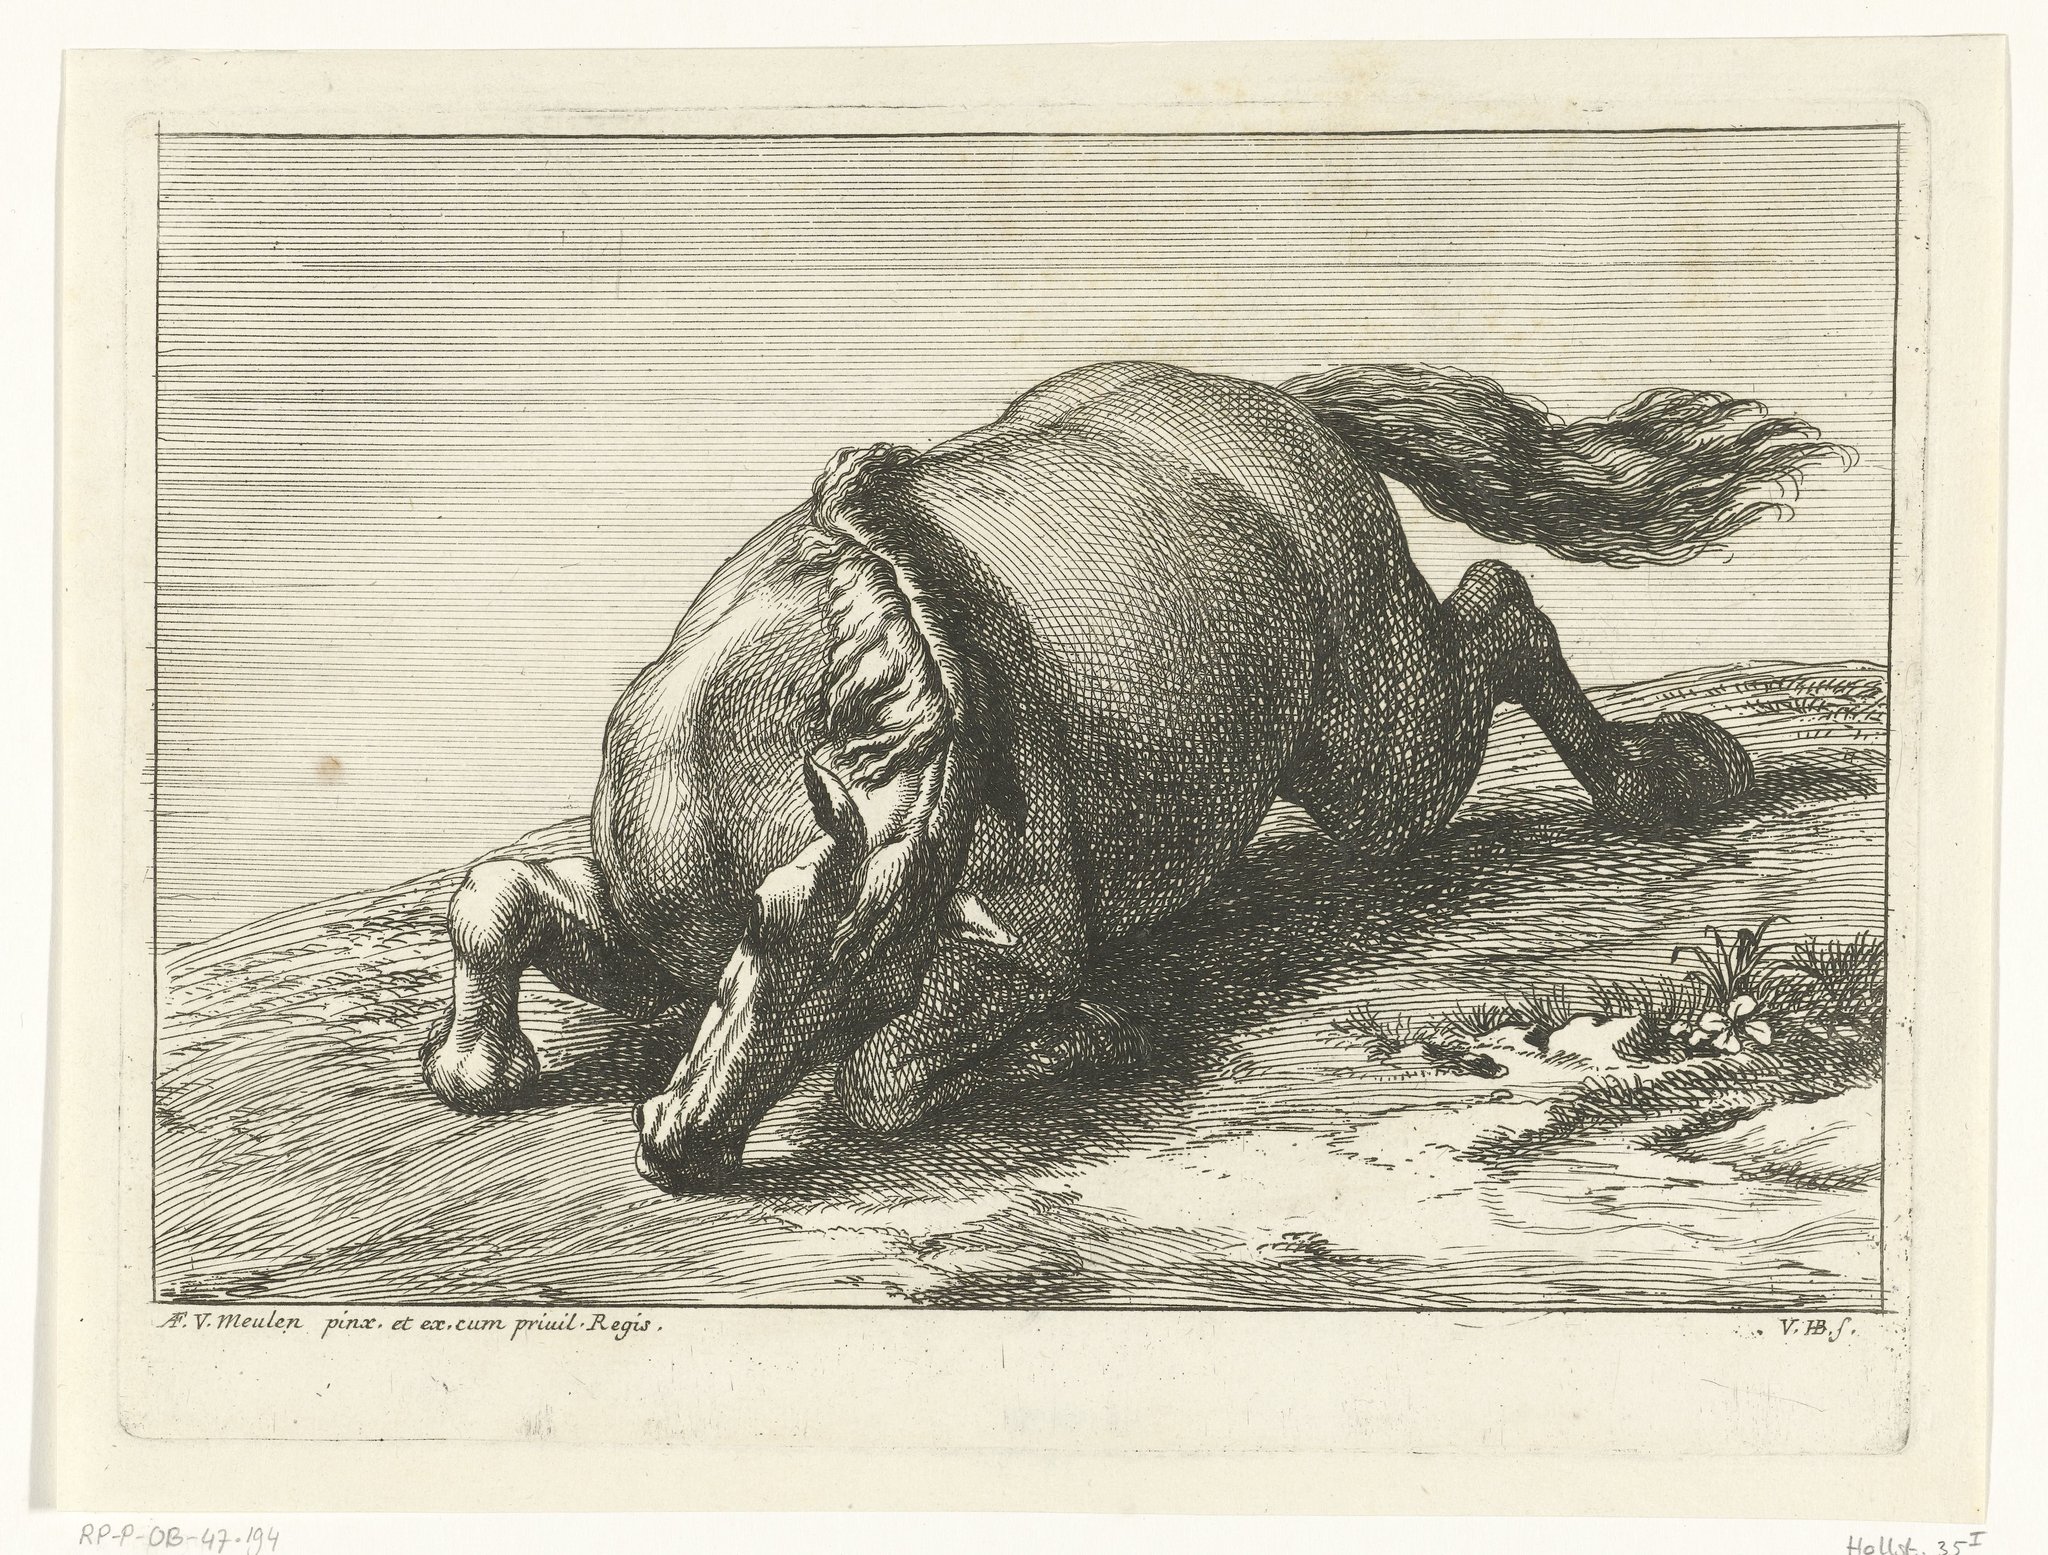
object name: print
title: Gesneuveld paard schuin van voren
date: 1674-1733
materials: paper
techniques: engraving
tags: horse (+ dying animal; death of animal; dead animal)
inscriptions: collector's mark: Lugt 2228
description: Op de buik liggend paard schuin van voren gezien.